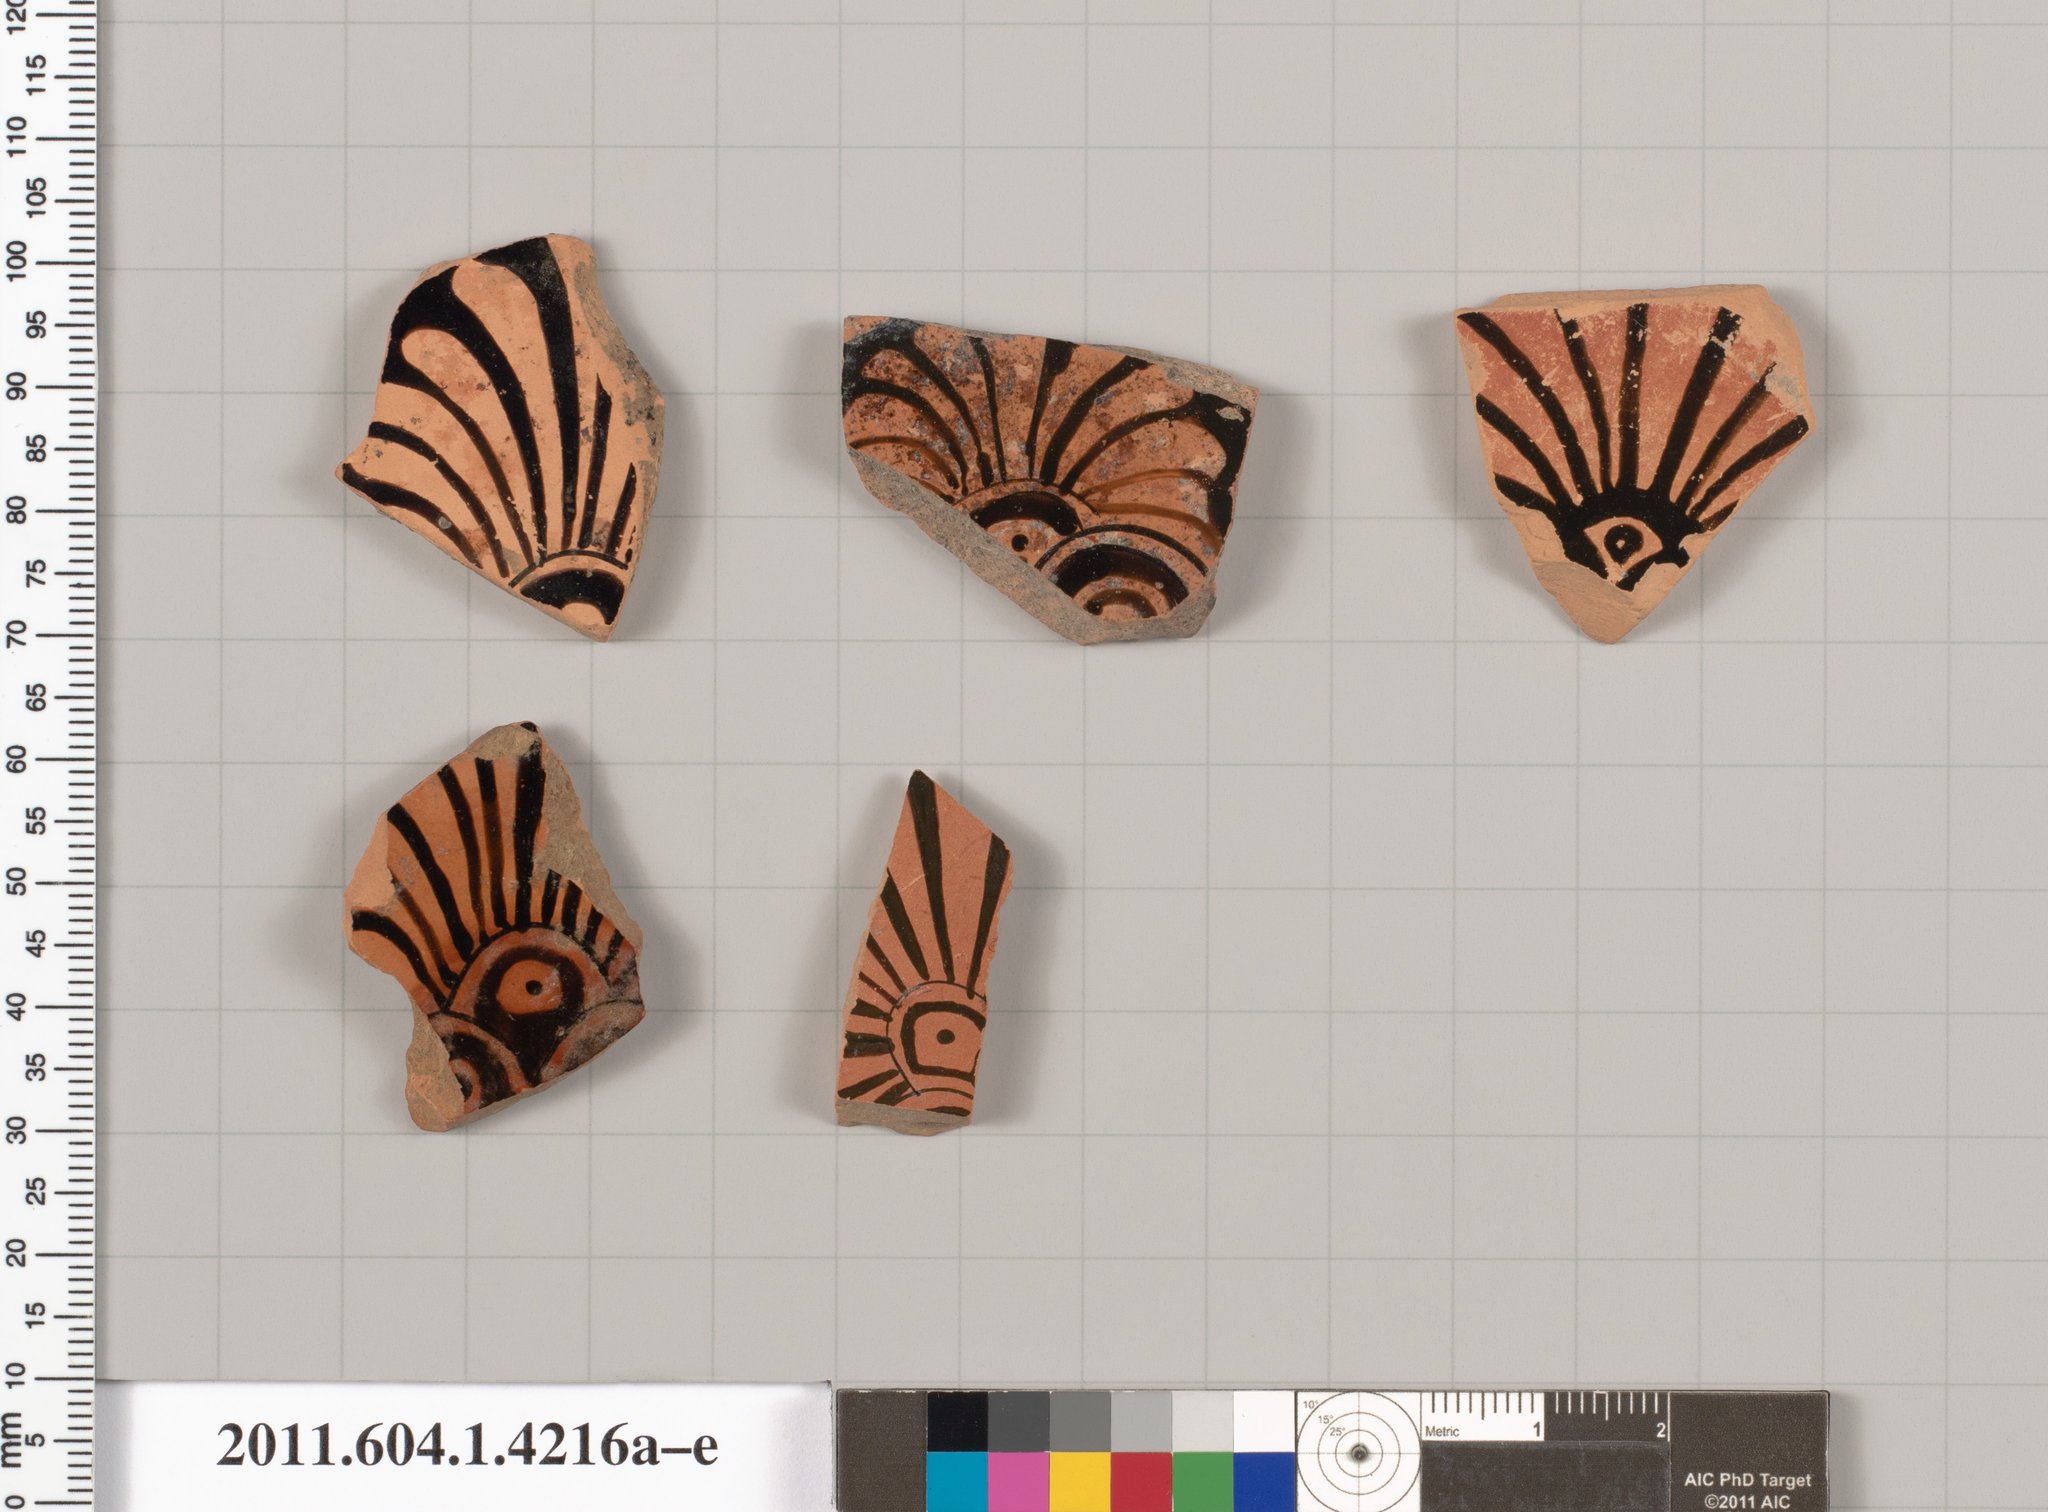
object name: kylix fragment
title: Terracotta fragments of kylikes (drinking cups)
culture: greek, attic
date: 500-451 BCE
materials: terracotta